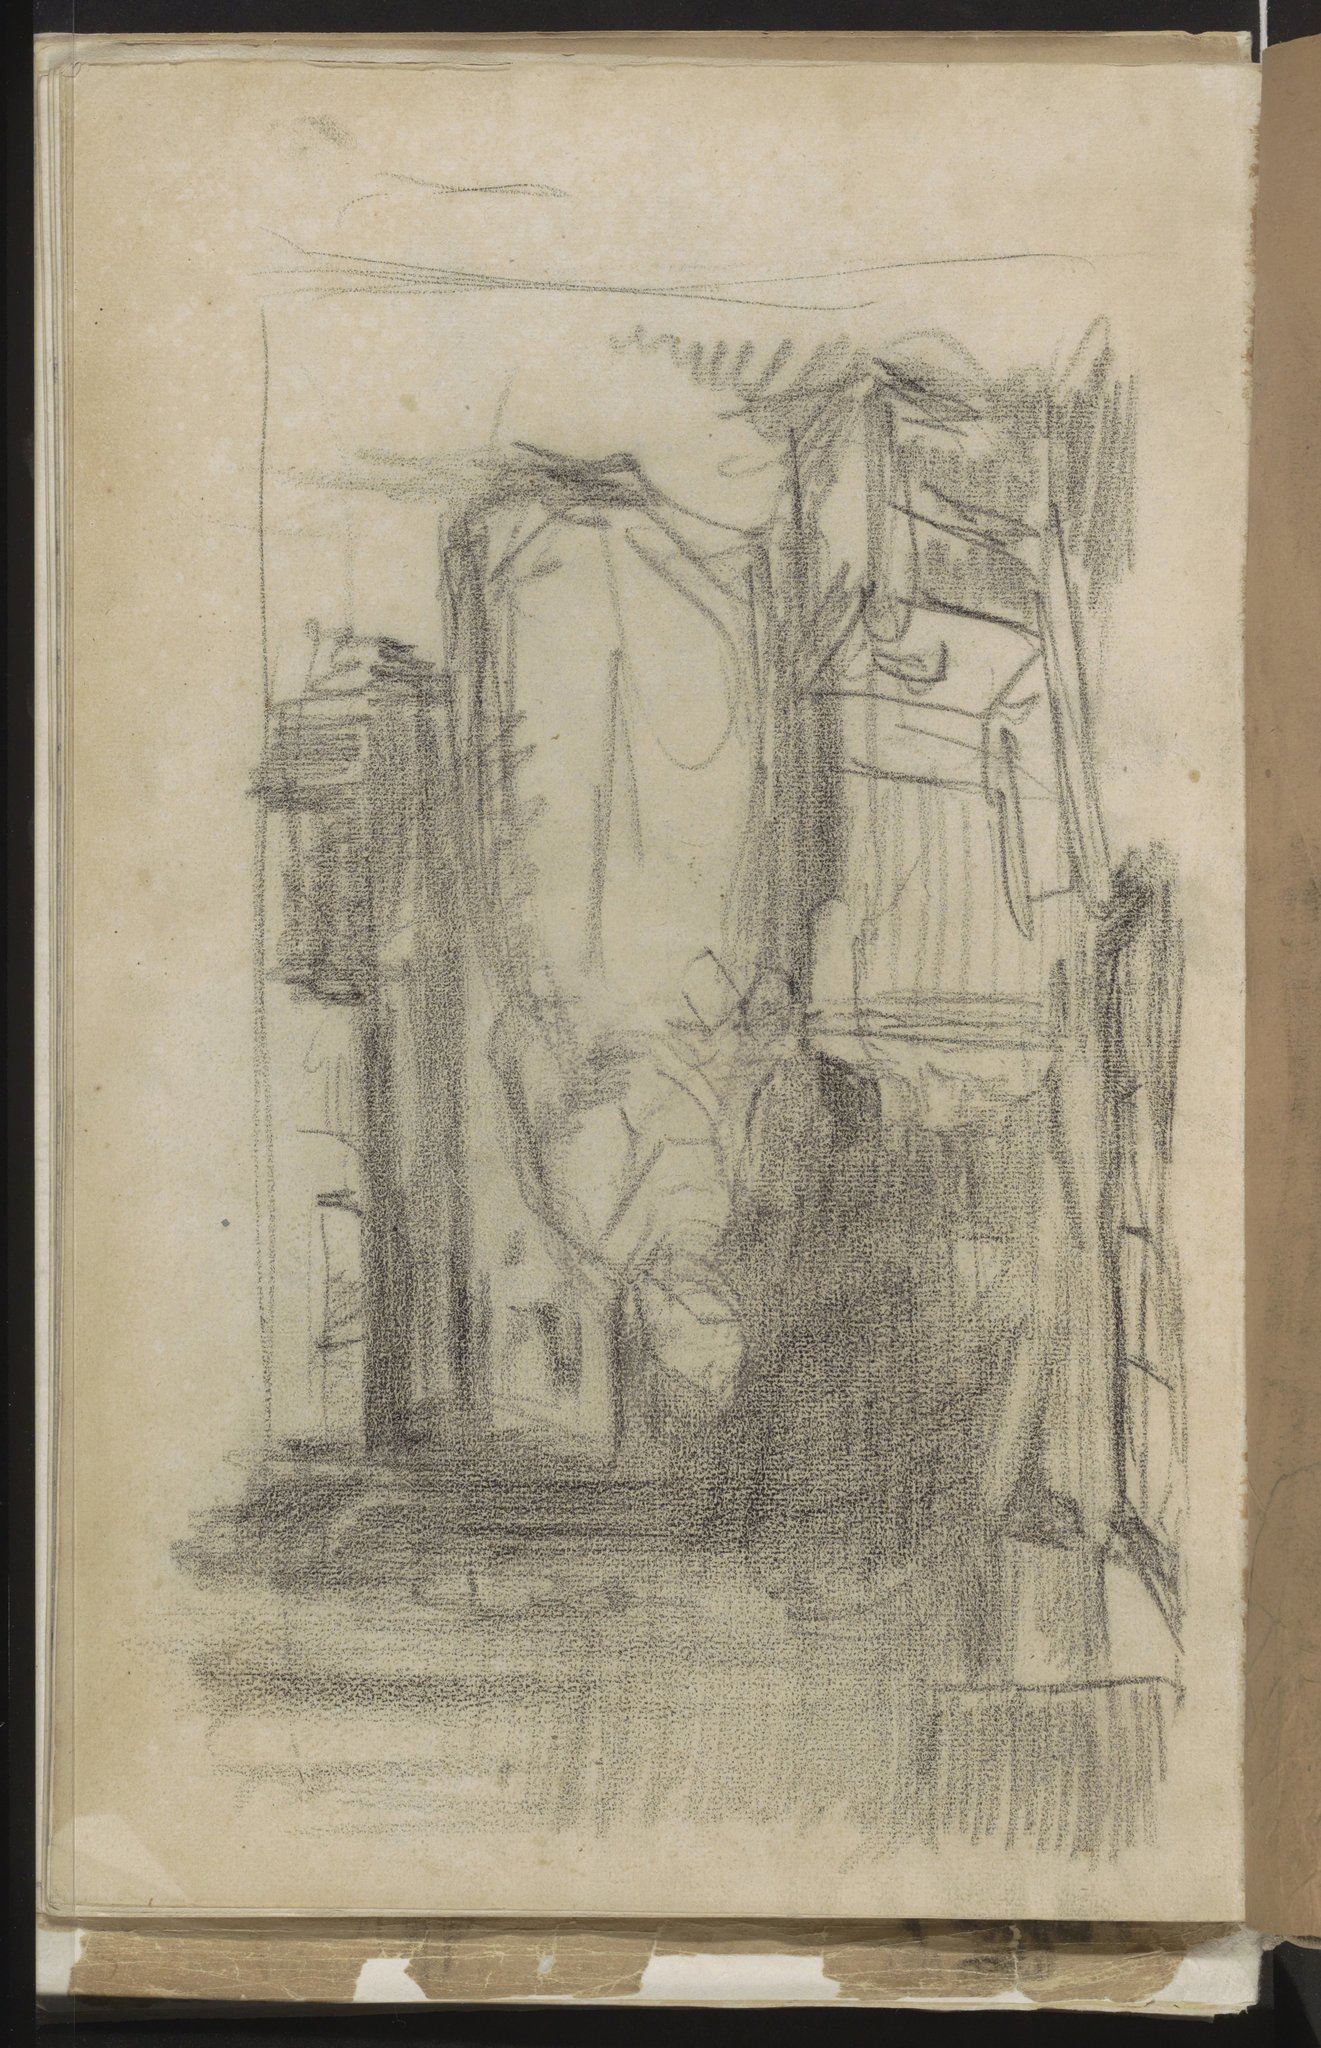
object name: sketchbook leaf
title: Vrouw in een boereninterieur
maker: albert neuhuys (1844-1914)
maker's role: draughtsman, painter, print maker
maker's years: 1844-1914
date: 1854-1914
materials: chalk, paper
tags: standing figure, adult woman, rural housing, e.g. country-house, villa, cottage, interior of the house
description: Blad 49 verso uit een schetsboek met 53 bladen.